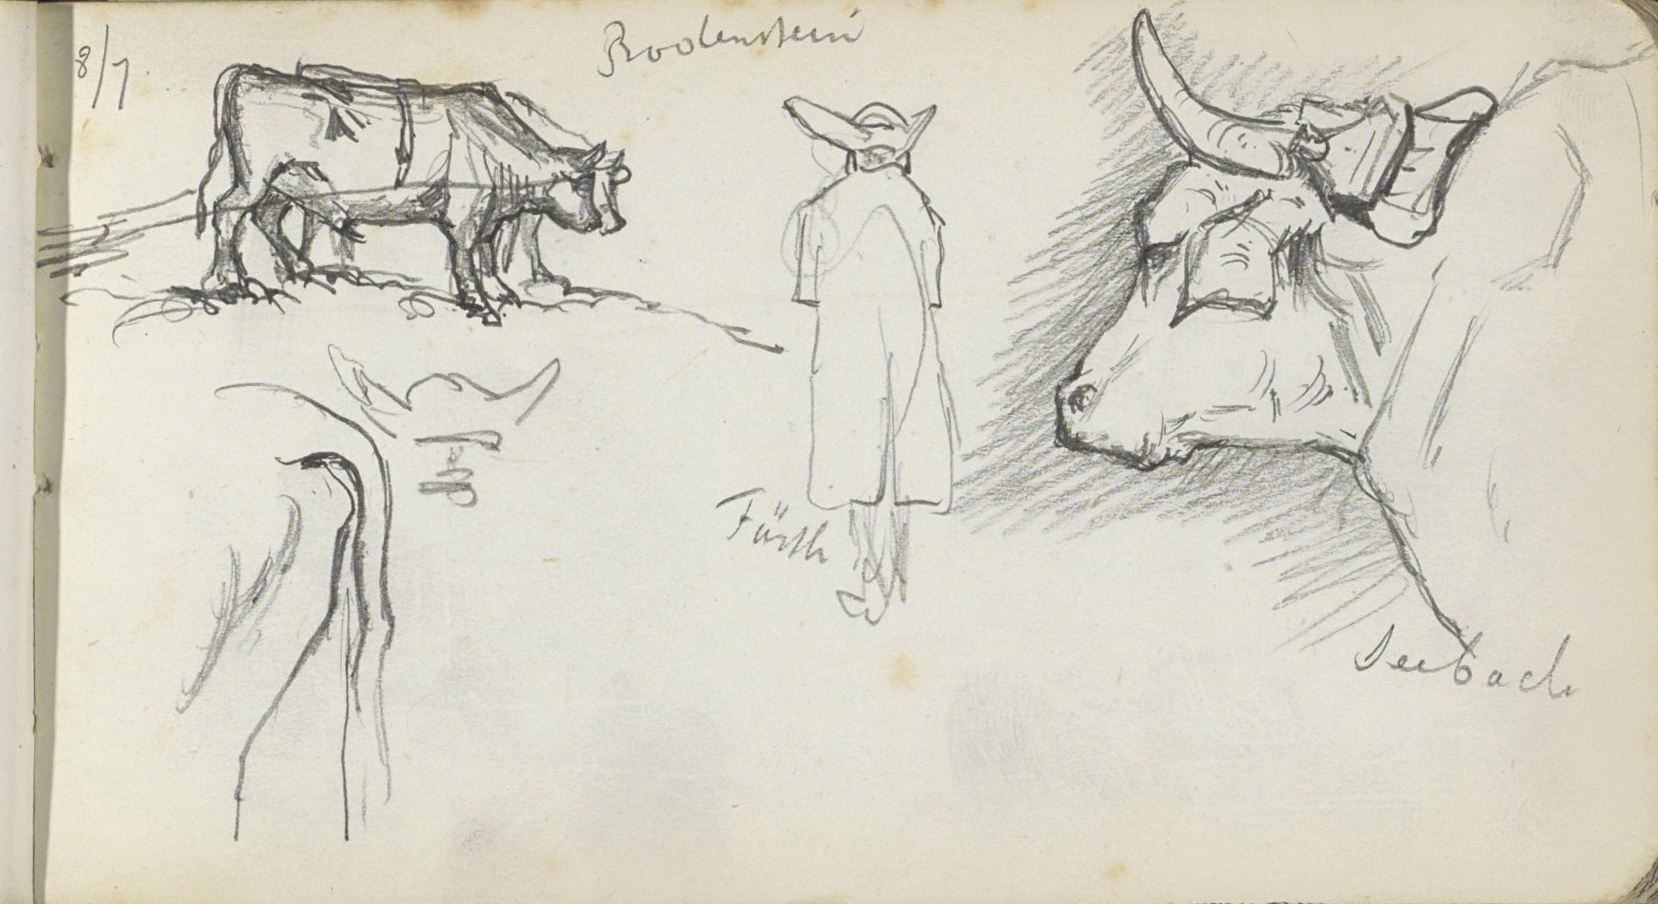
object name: sketchbook leaf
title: Ossen te Rodenstein en Seebach en een man uit Fürth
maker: geo poggenbeek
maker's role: draughtsman, painter, print maker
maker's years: 1853-1903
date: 1807-1876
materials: paper, pencil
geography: seebach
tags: standing figure, ox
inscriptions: date and inscription: ‘8/7/ Rodenstein/ Fürth/ Seebach’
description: Blad 30 recto uit een schetsboek met 69 bladen.